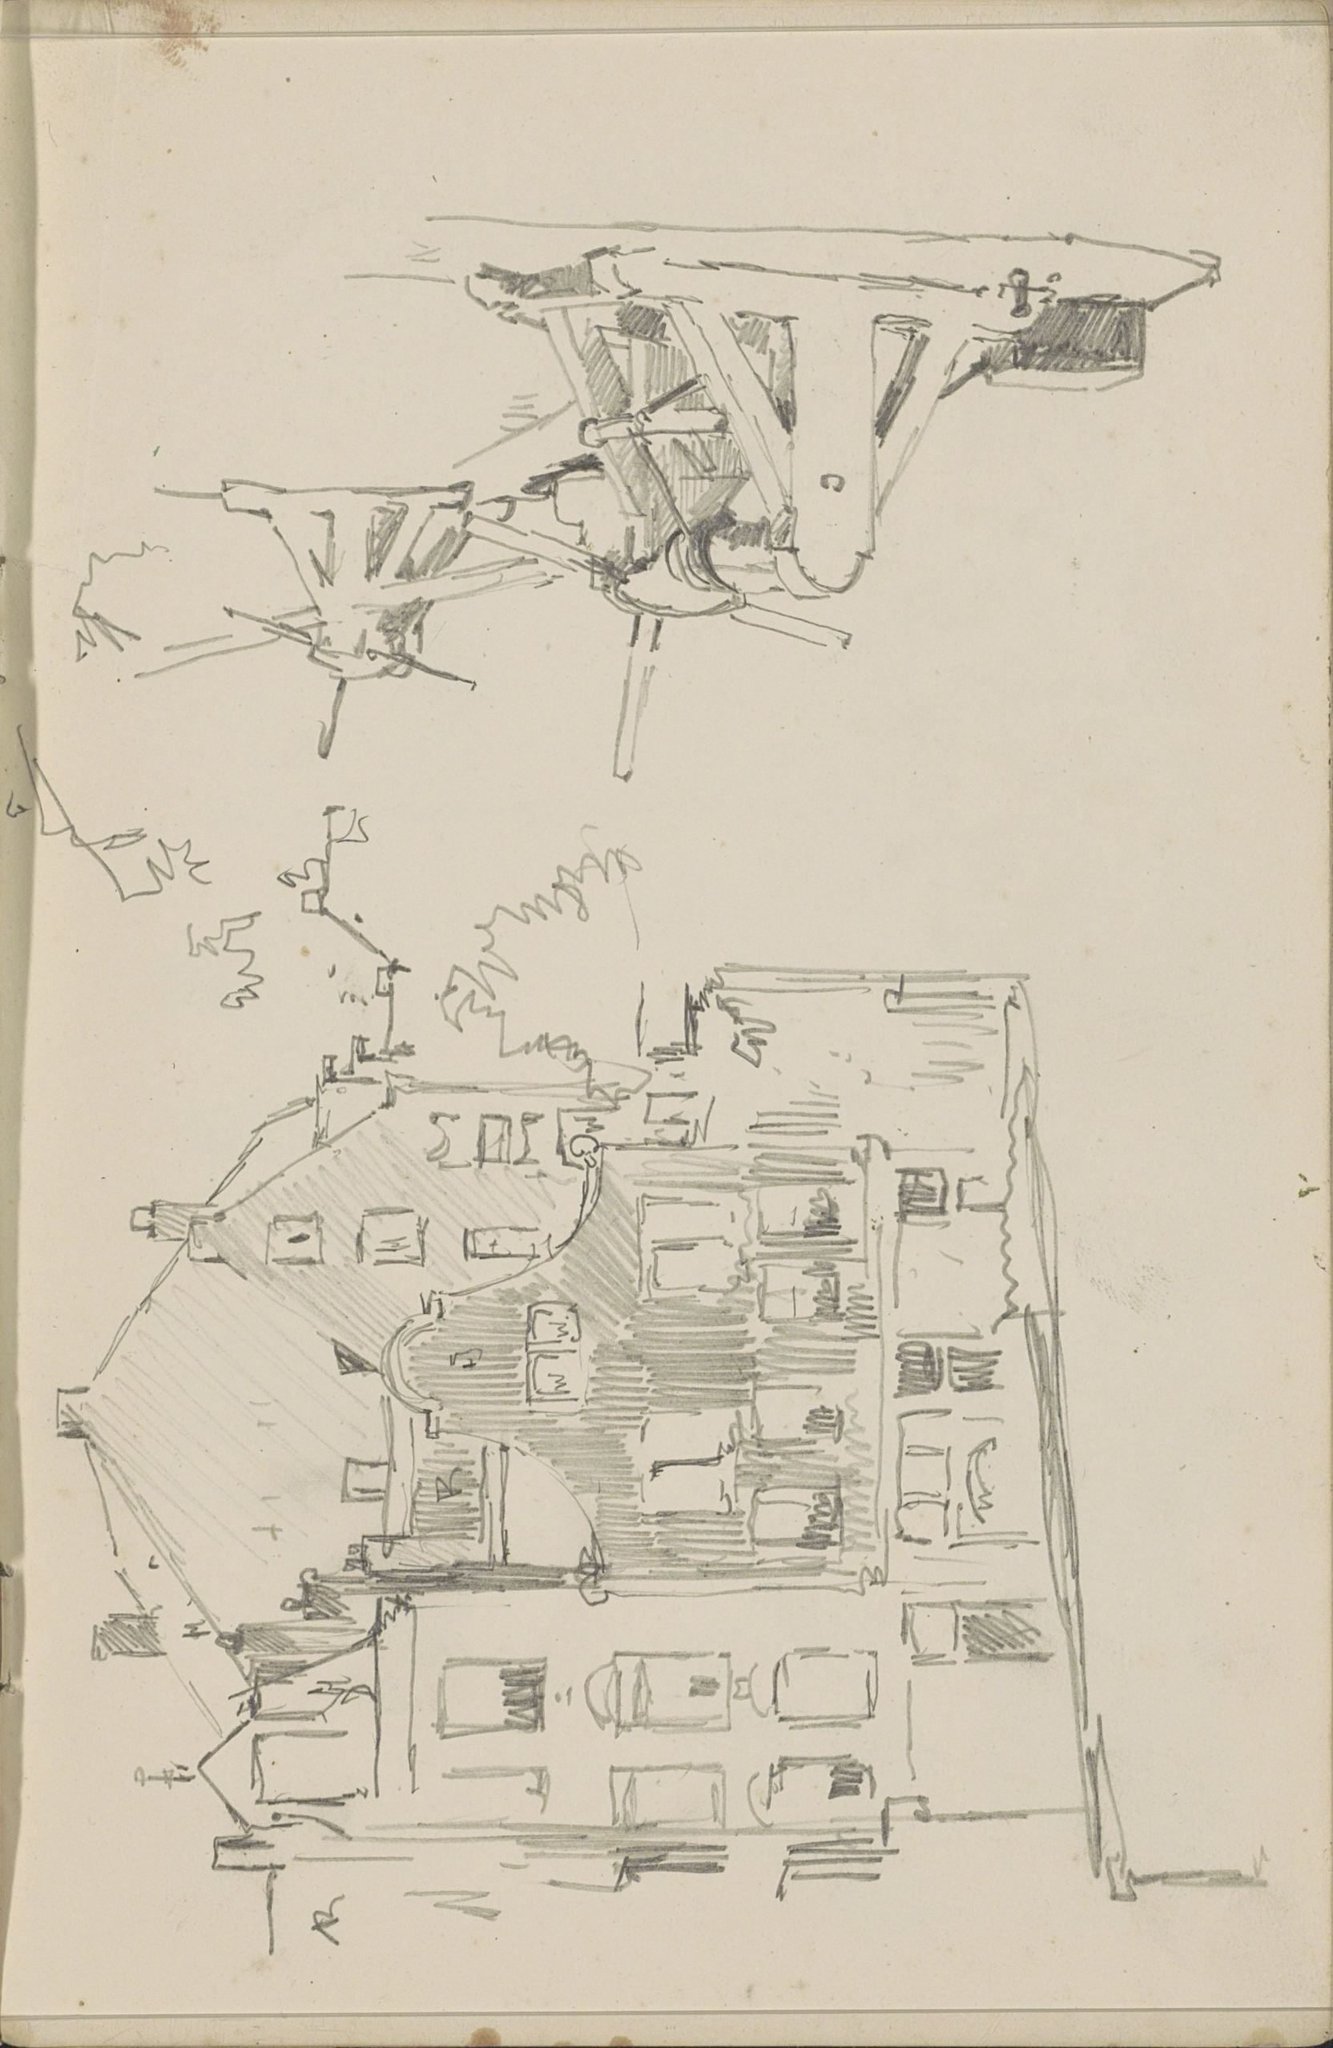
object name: sketchbook leaf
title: Gezicht op een rij pakhuizen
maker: cornelis vreedenburgh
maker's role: draughtsman, print maker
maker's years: 1880-1946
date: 1890-1946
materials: paper, pencil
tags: lift-lock, canal lock (+ variant), street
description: Tevens studies van werktuigen om sluizen mee te bedienen. Blad 21 recto uit een schetsboek met 45 bladen.